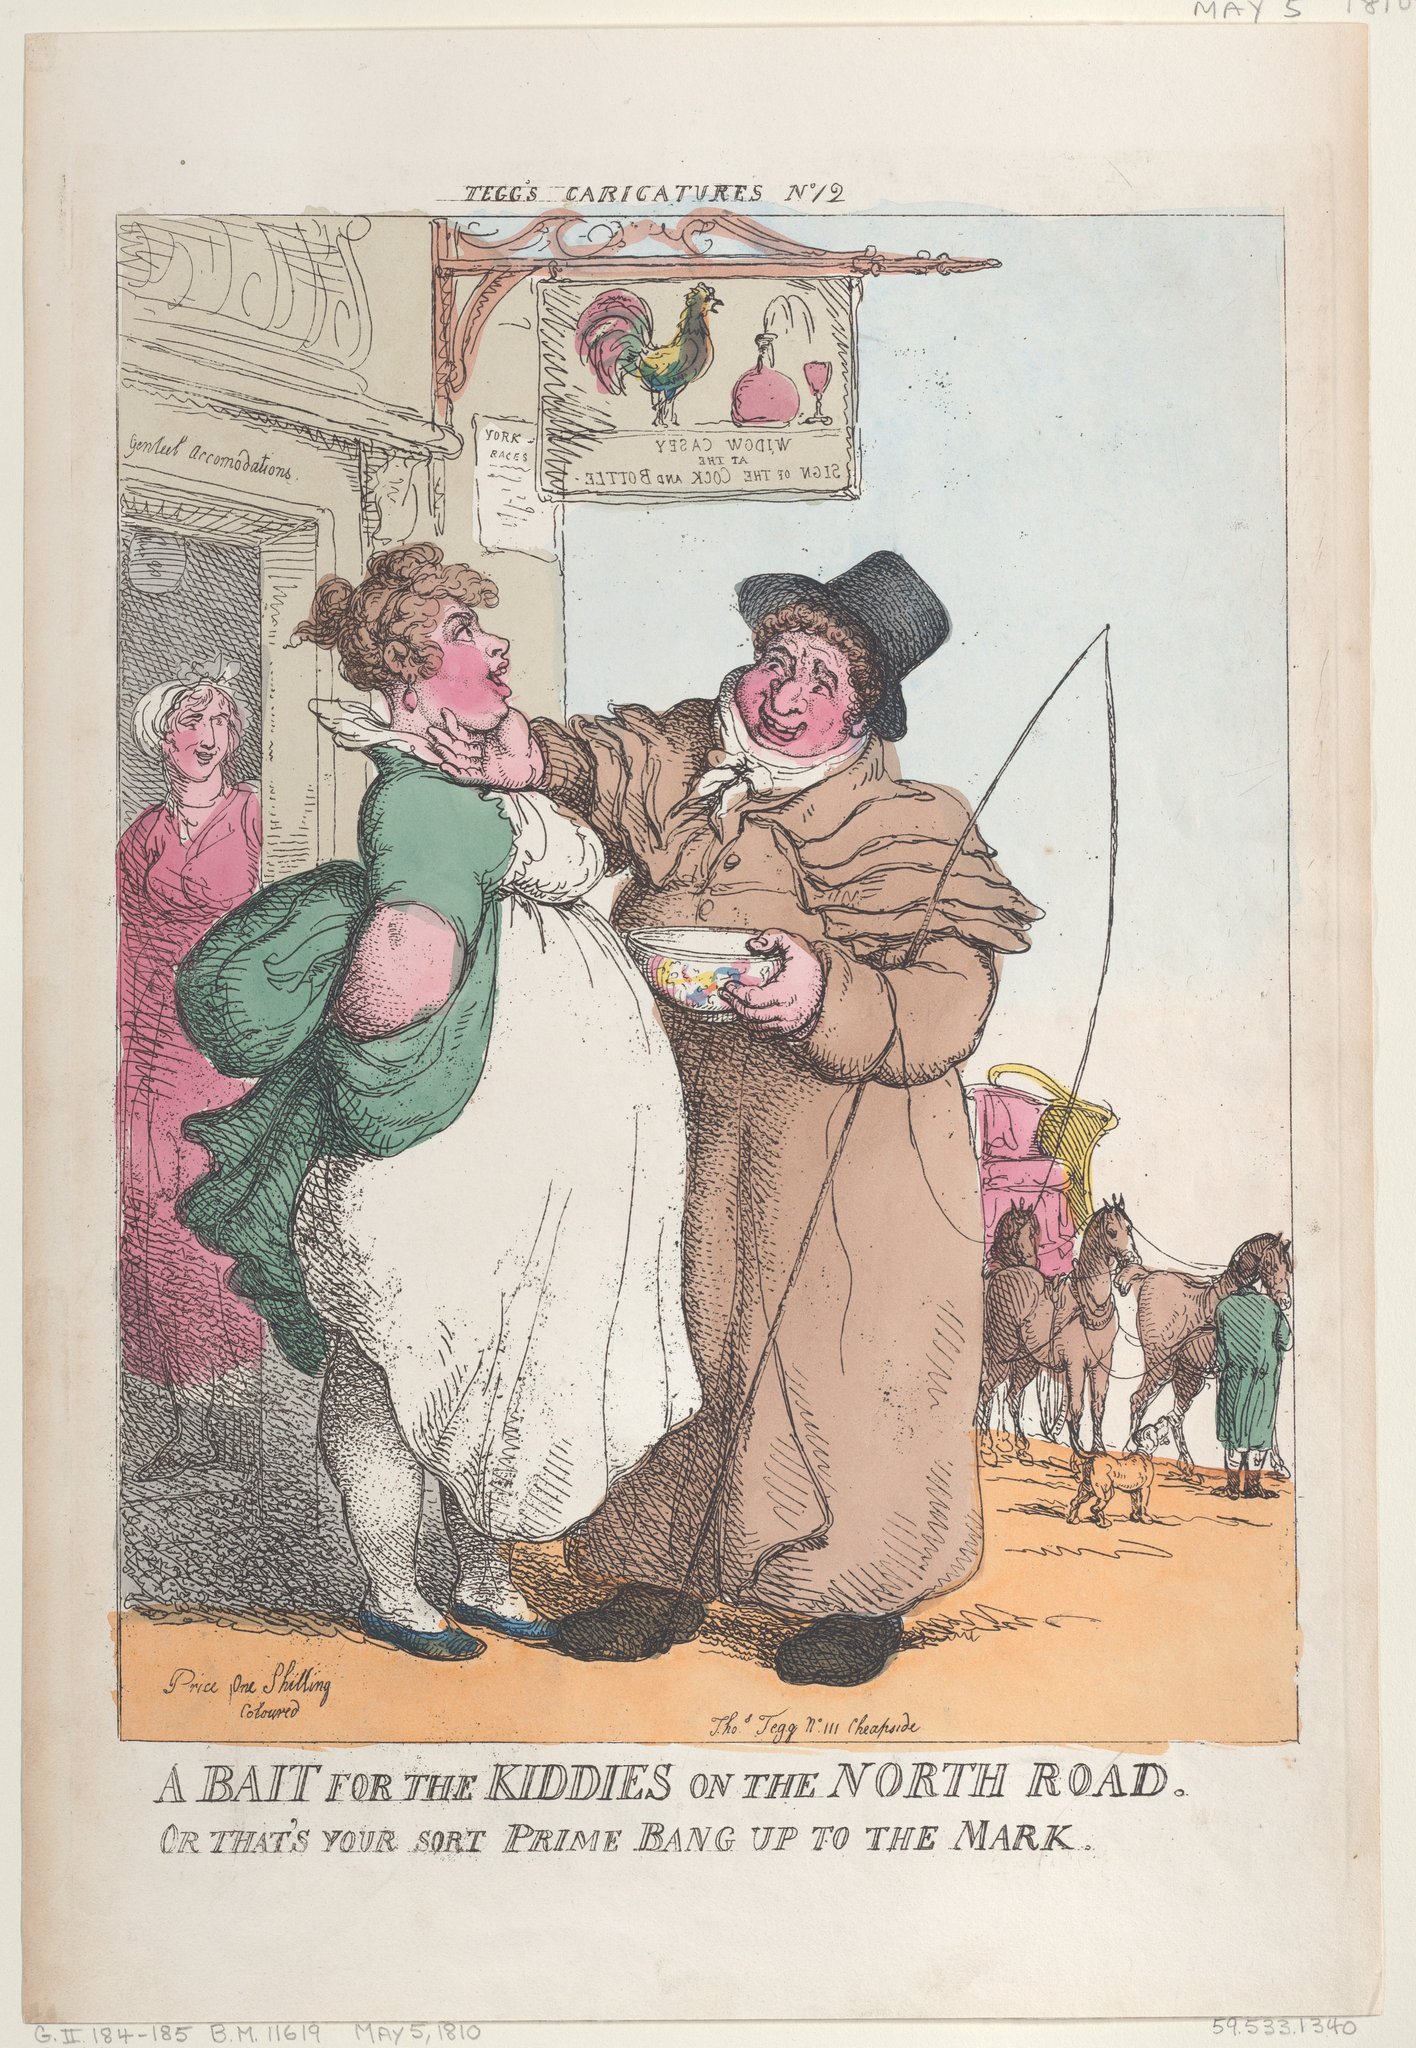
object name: print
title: A Bait for Kiddies on the North Road. Or That's Your Sort Prime Bang up the Mark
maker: thomas rowlandson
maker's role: artist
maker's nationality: british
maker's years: 1757-1827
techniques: etching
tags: satire,men,women,carriages